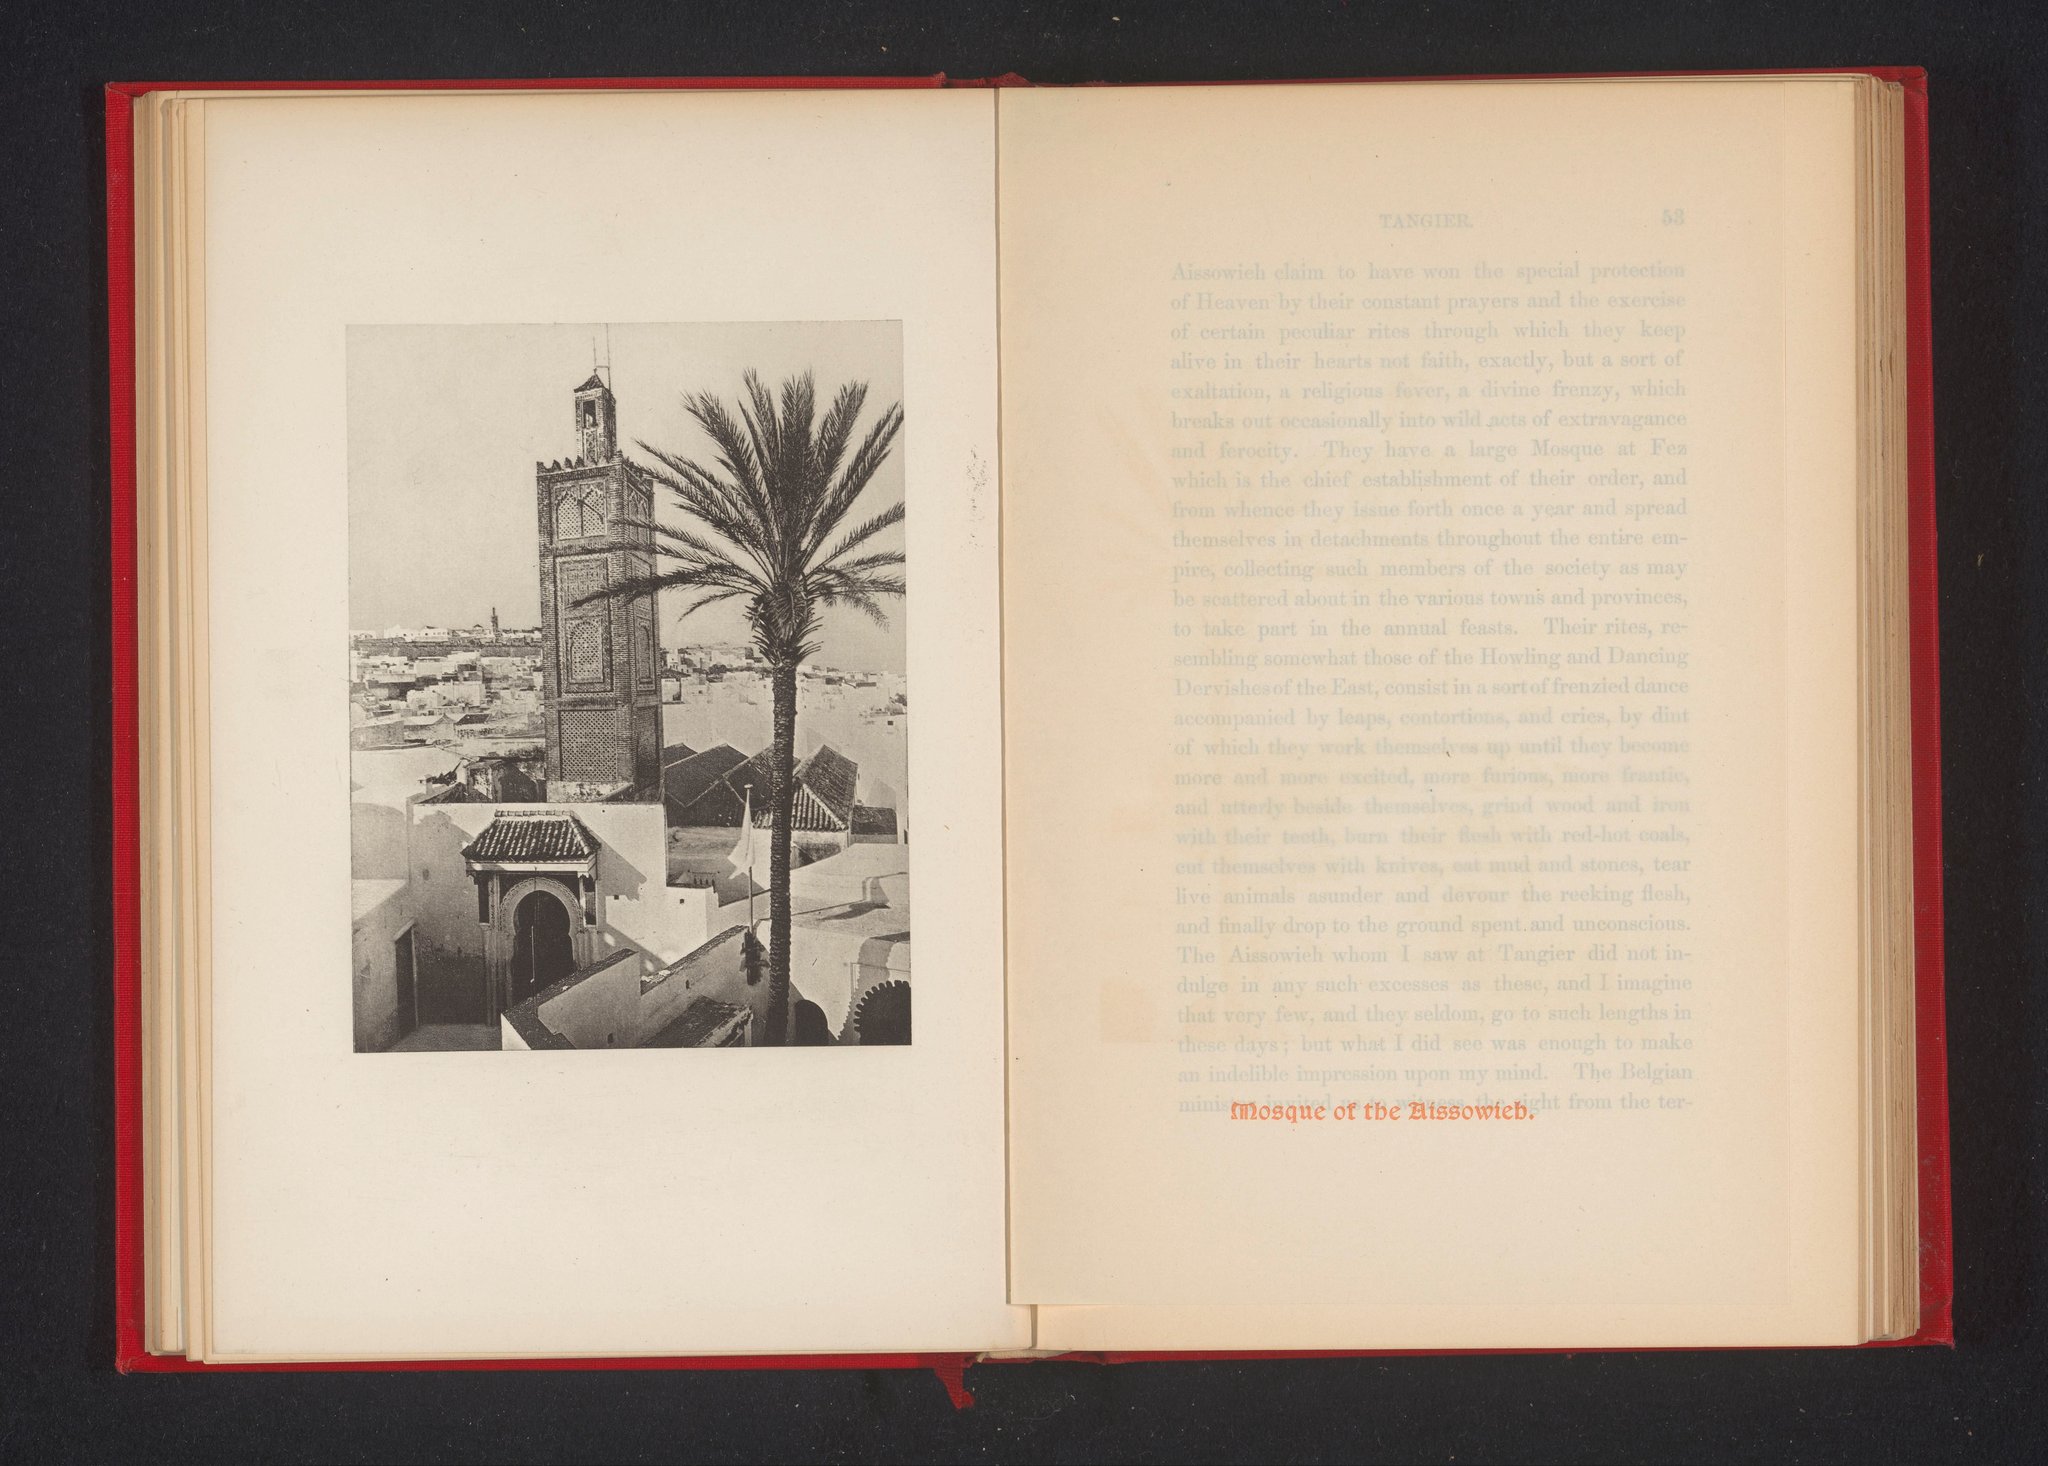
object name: page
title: Gezicht op de moskee van de Aïssawiyya te Tanger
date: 1887-1897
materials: paper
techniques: photoaquatint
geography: tanger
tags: temple, shrine ~ islam, mohammedanism, façade (of house or building)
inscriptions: title: ‘Mosque of the Aissowieh.’